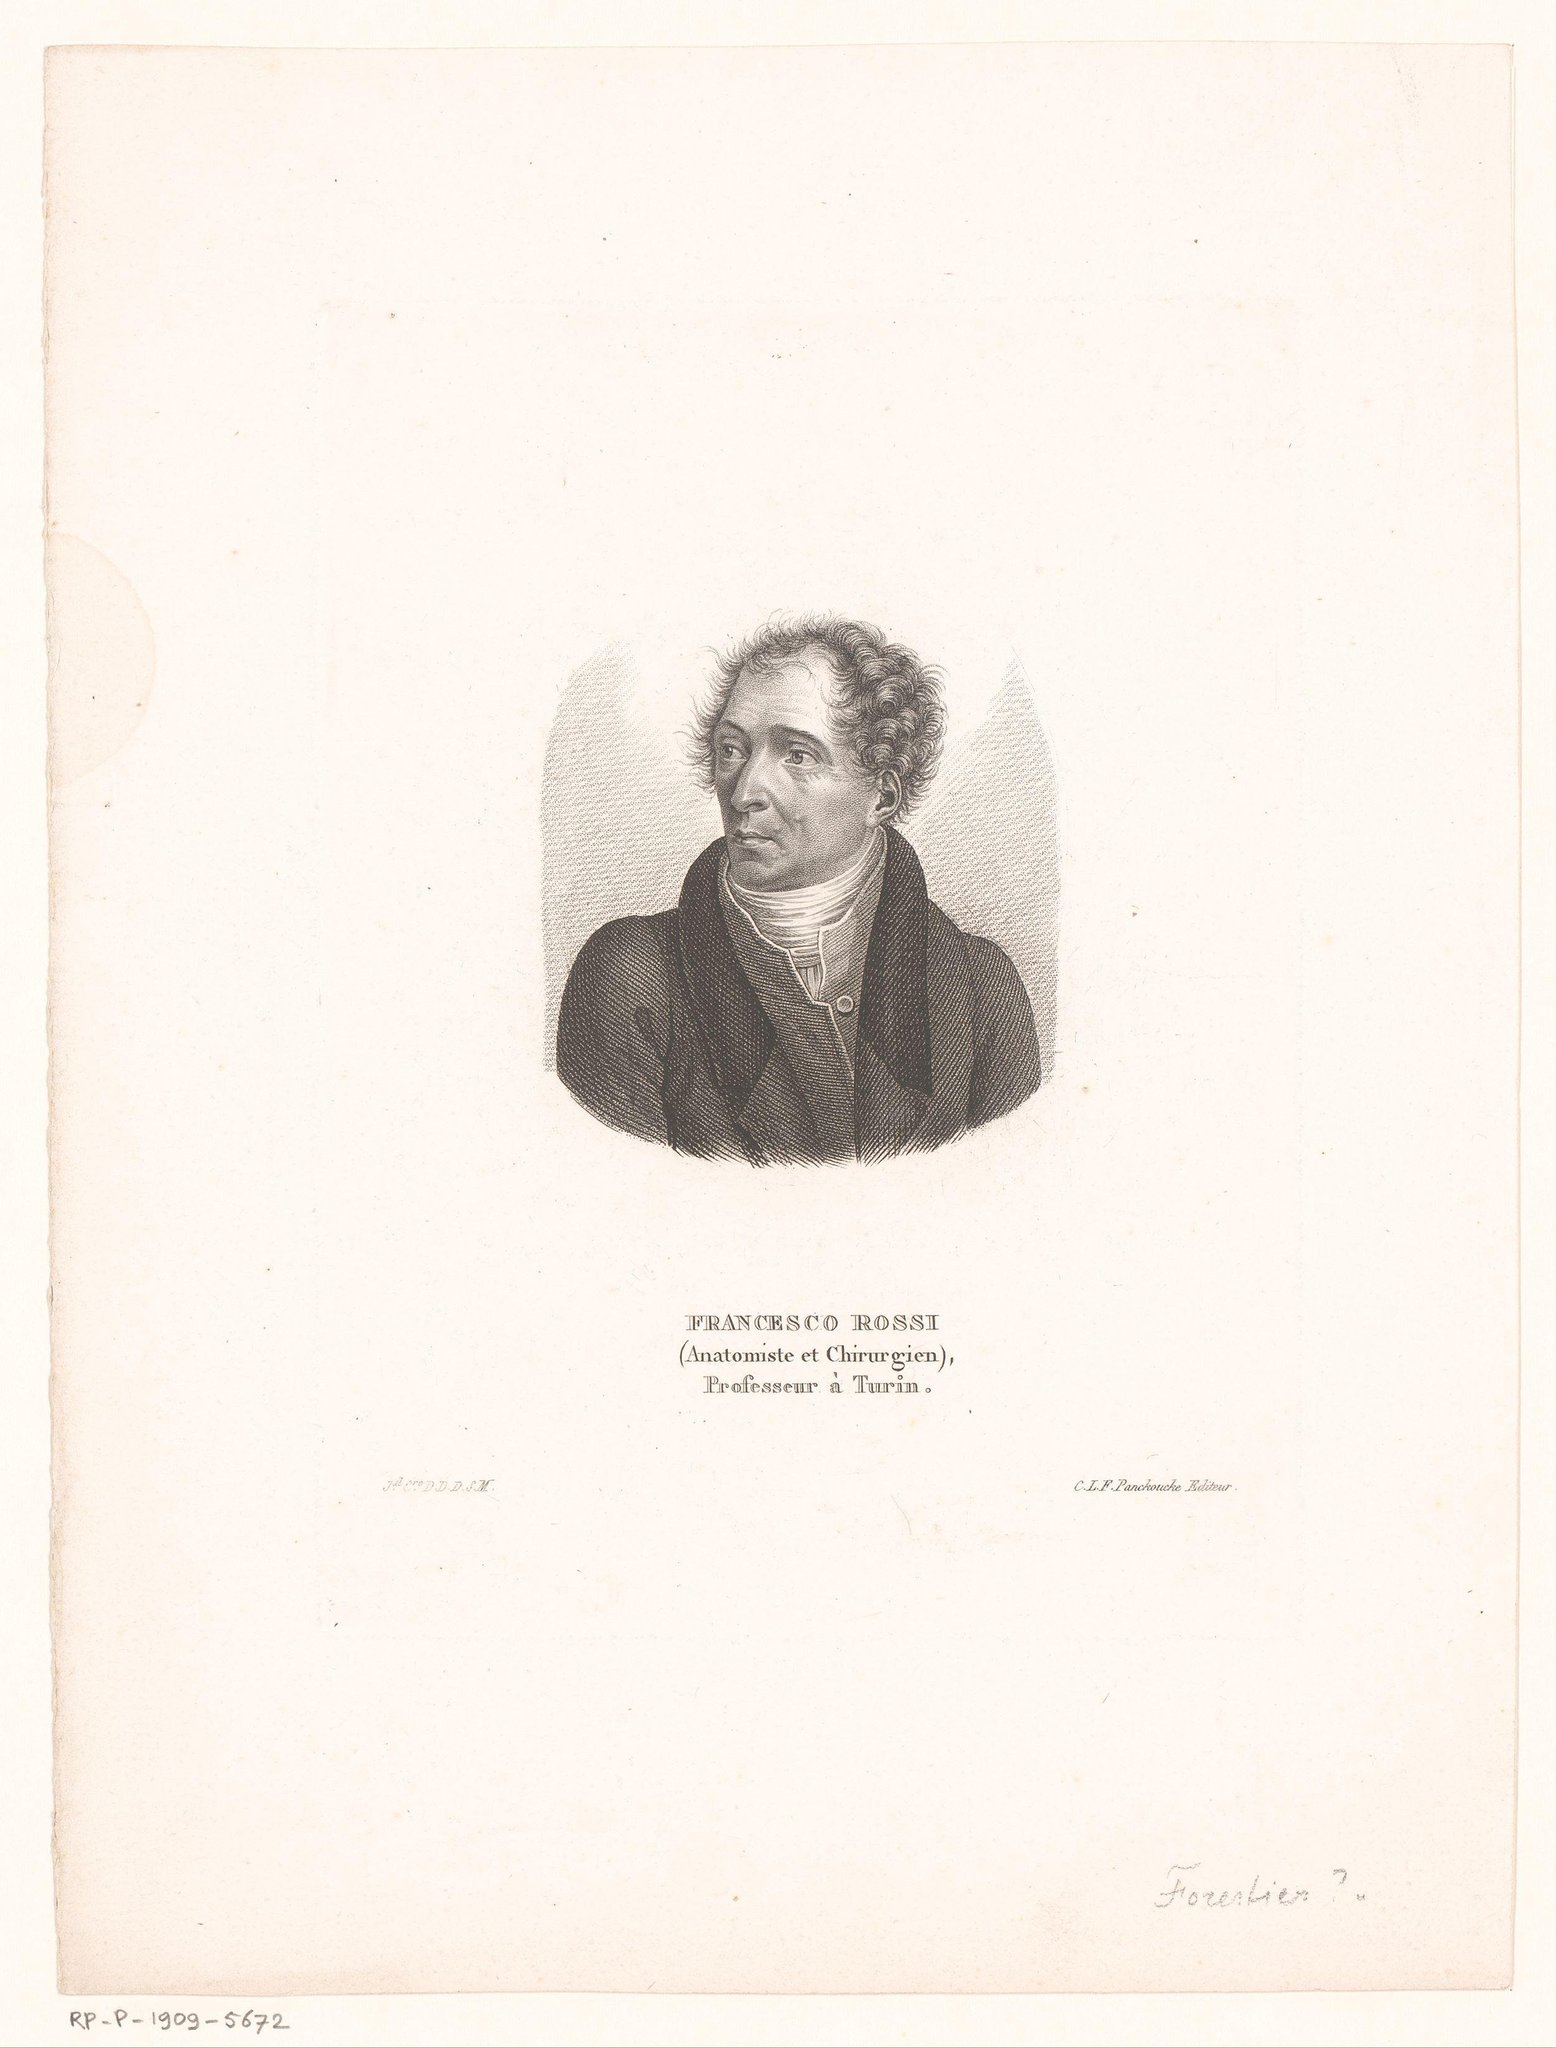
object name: print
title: Portret van Francesco Rossi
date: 1818-1832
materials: paper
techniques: engraving, roulette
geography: paris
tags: historical persons, barber; surgeon, physician, doctor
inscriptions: collector's mark: Lugt 2228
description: Prent uit: Journal complémentaire du Dictionnaire des sciences médicales. Parijs: Panckoucke, Charles Louis Fleury, 1818-1832.